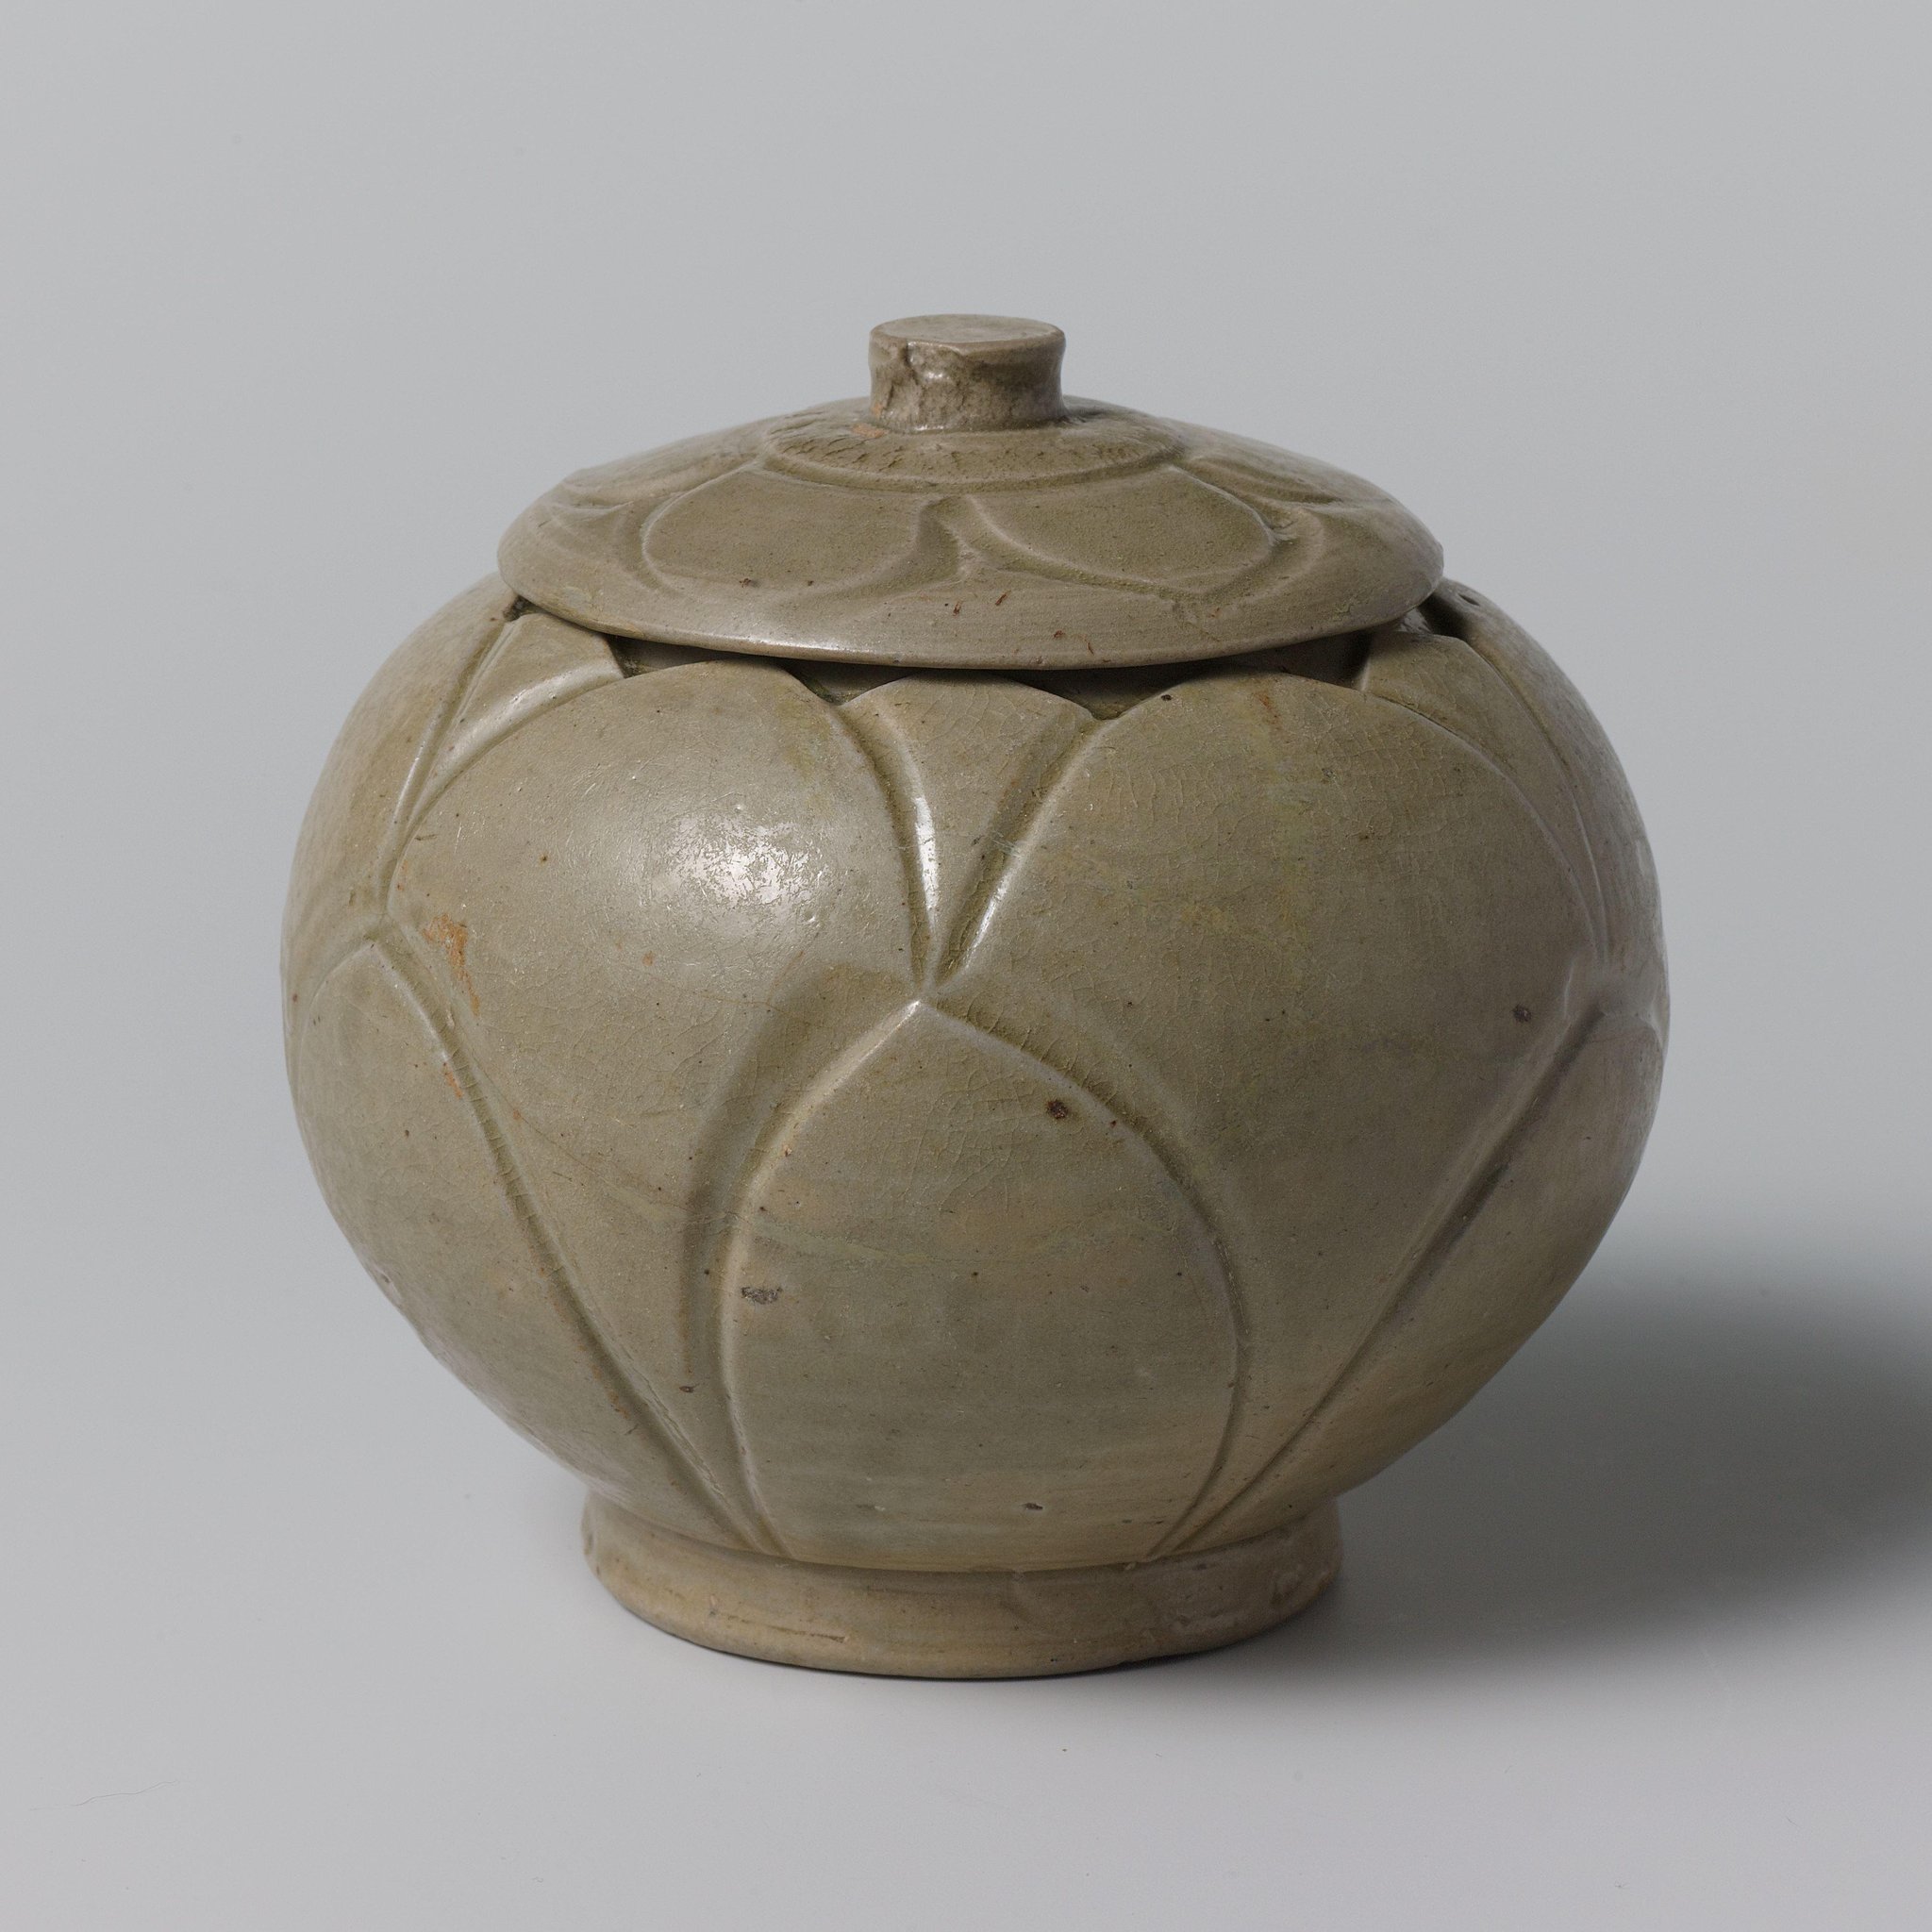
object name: lid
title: Covered jar with incised flowerpetals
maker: Anonymous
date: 900-999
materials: glaze, stoneware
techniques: engraving, firing, turning, vitrification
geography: china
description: Dekselpot van steengoed met een bolvormig lichaam, bedekt met een groen glazuur. Op de deksel een band met ingegrifte bladmotieven. Celadon (Yue).